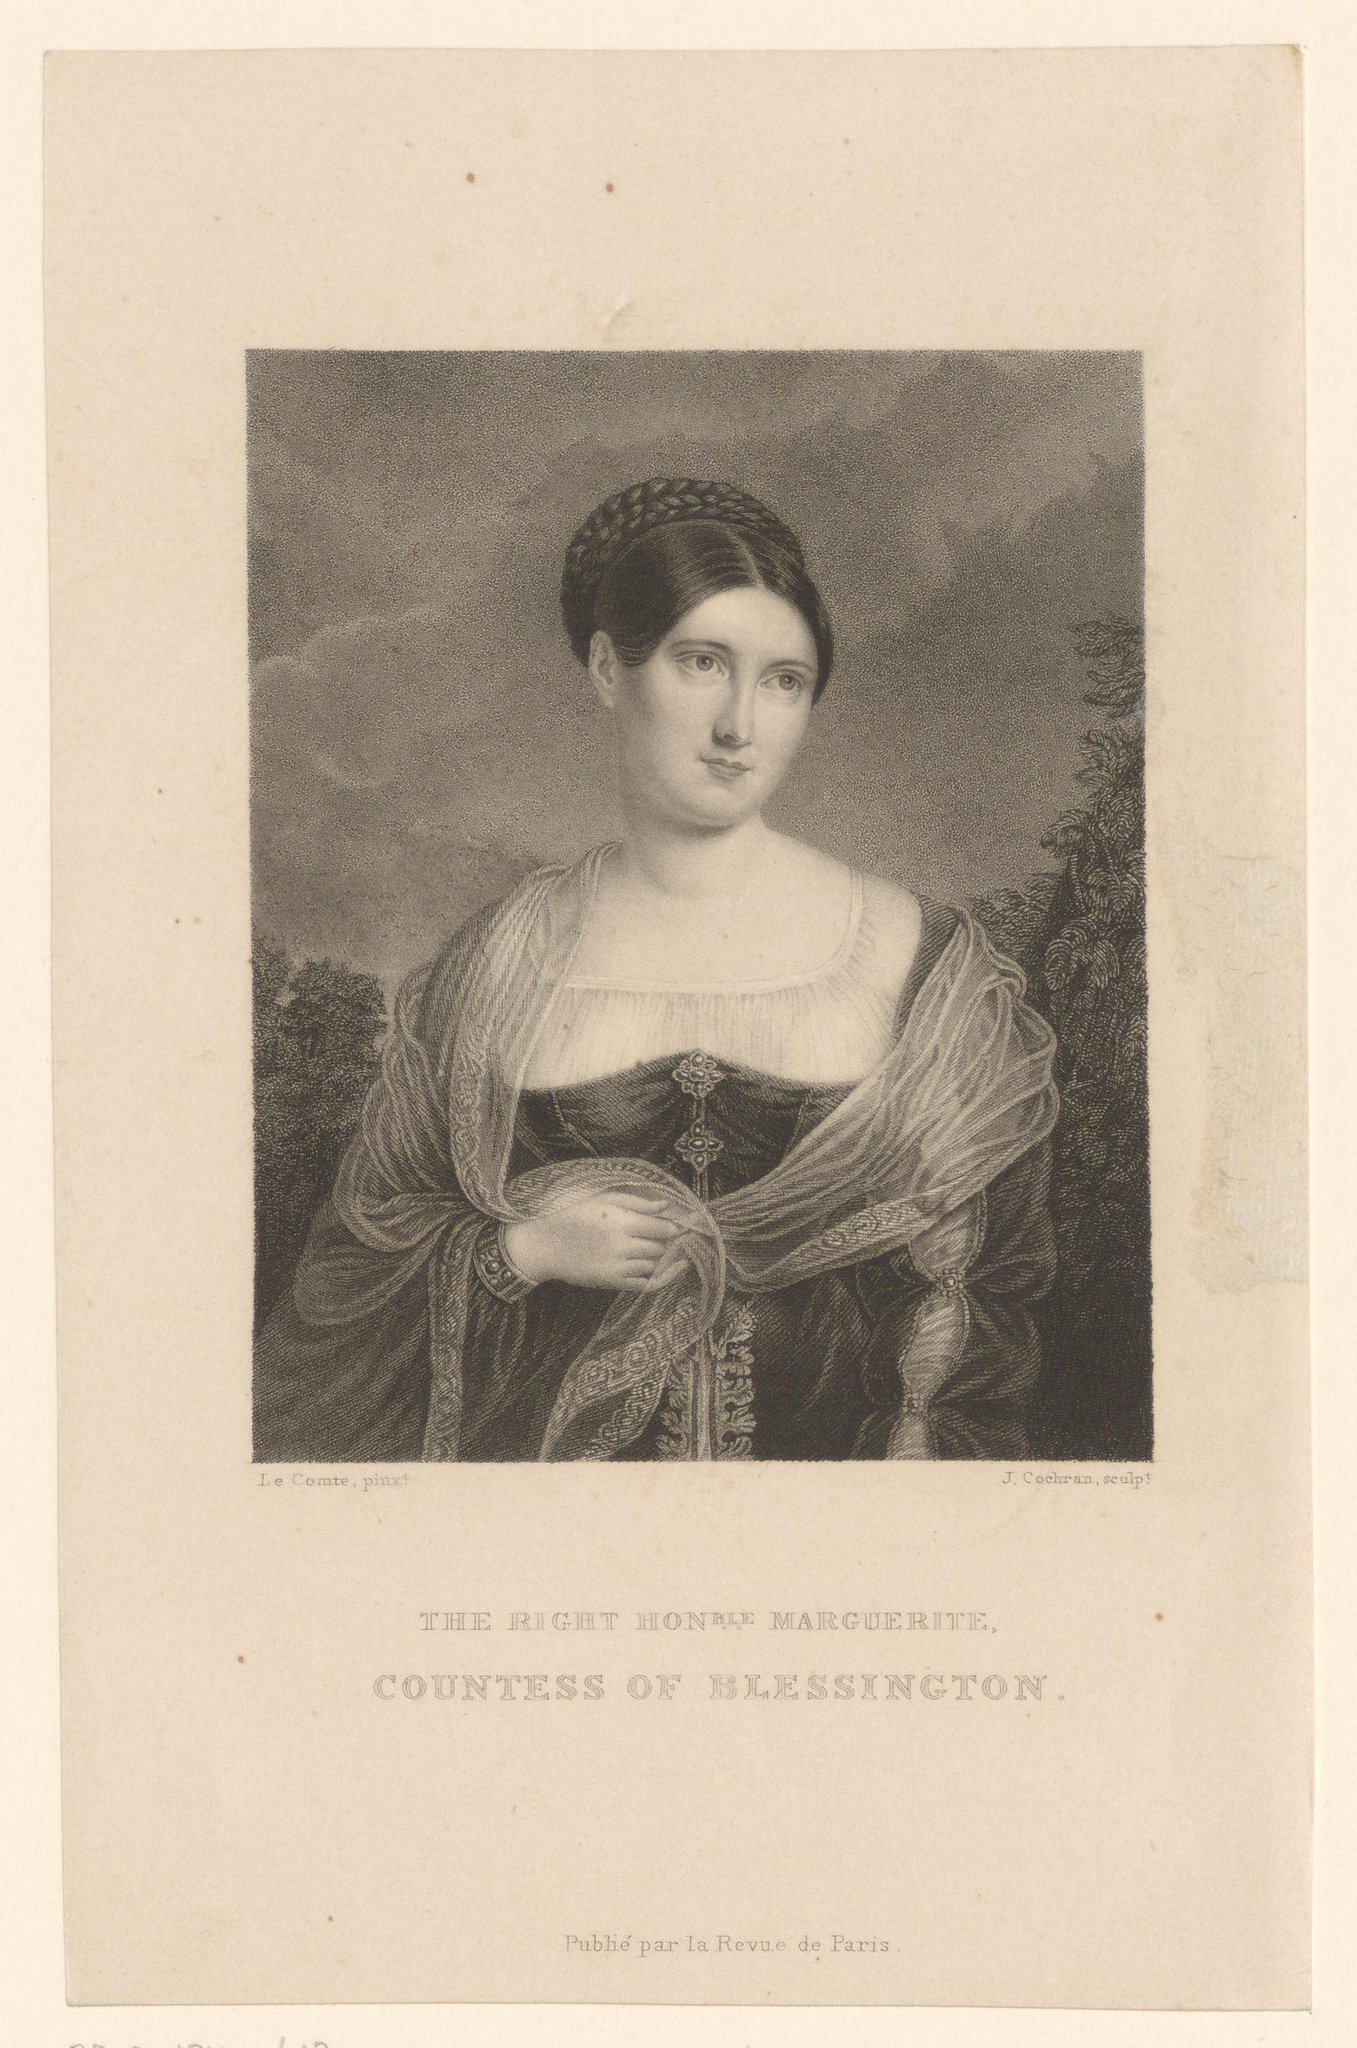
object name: print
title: Portret van Marguerite Gardiner, gravin van Blessington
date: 1835-1836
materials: paper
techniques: etching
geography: paris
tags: historical persons, writer, poet, author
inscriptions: collector's mark: Lugt 2228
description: Prent gebruikt in: The Court magazine and belle assemblée [1835-1836].